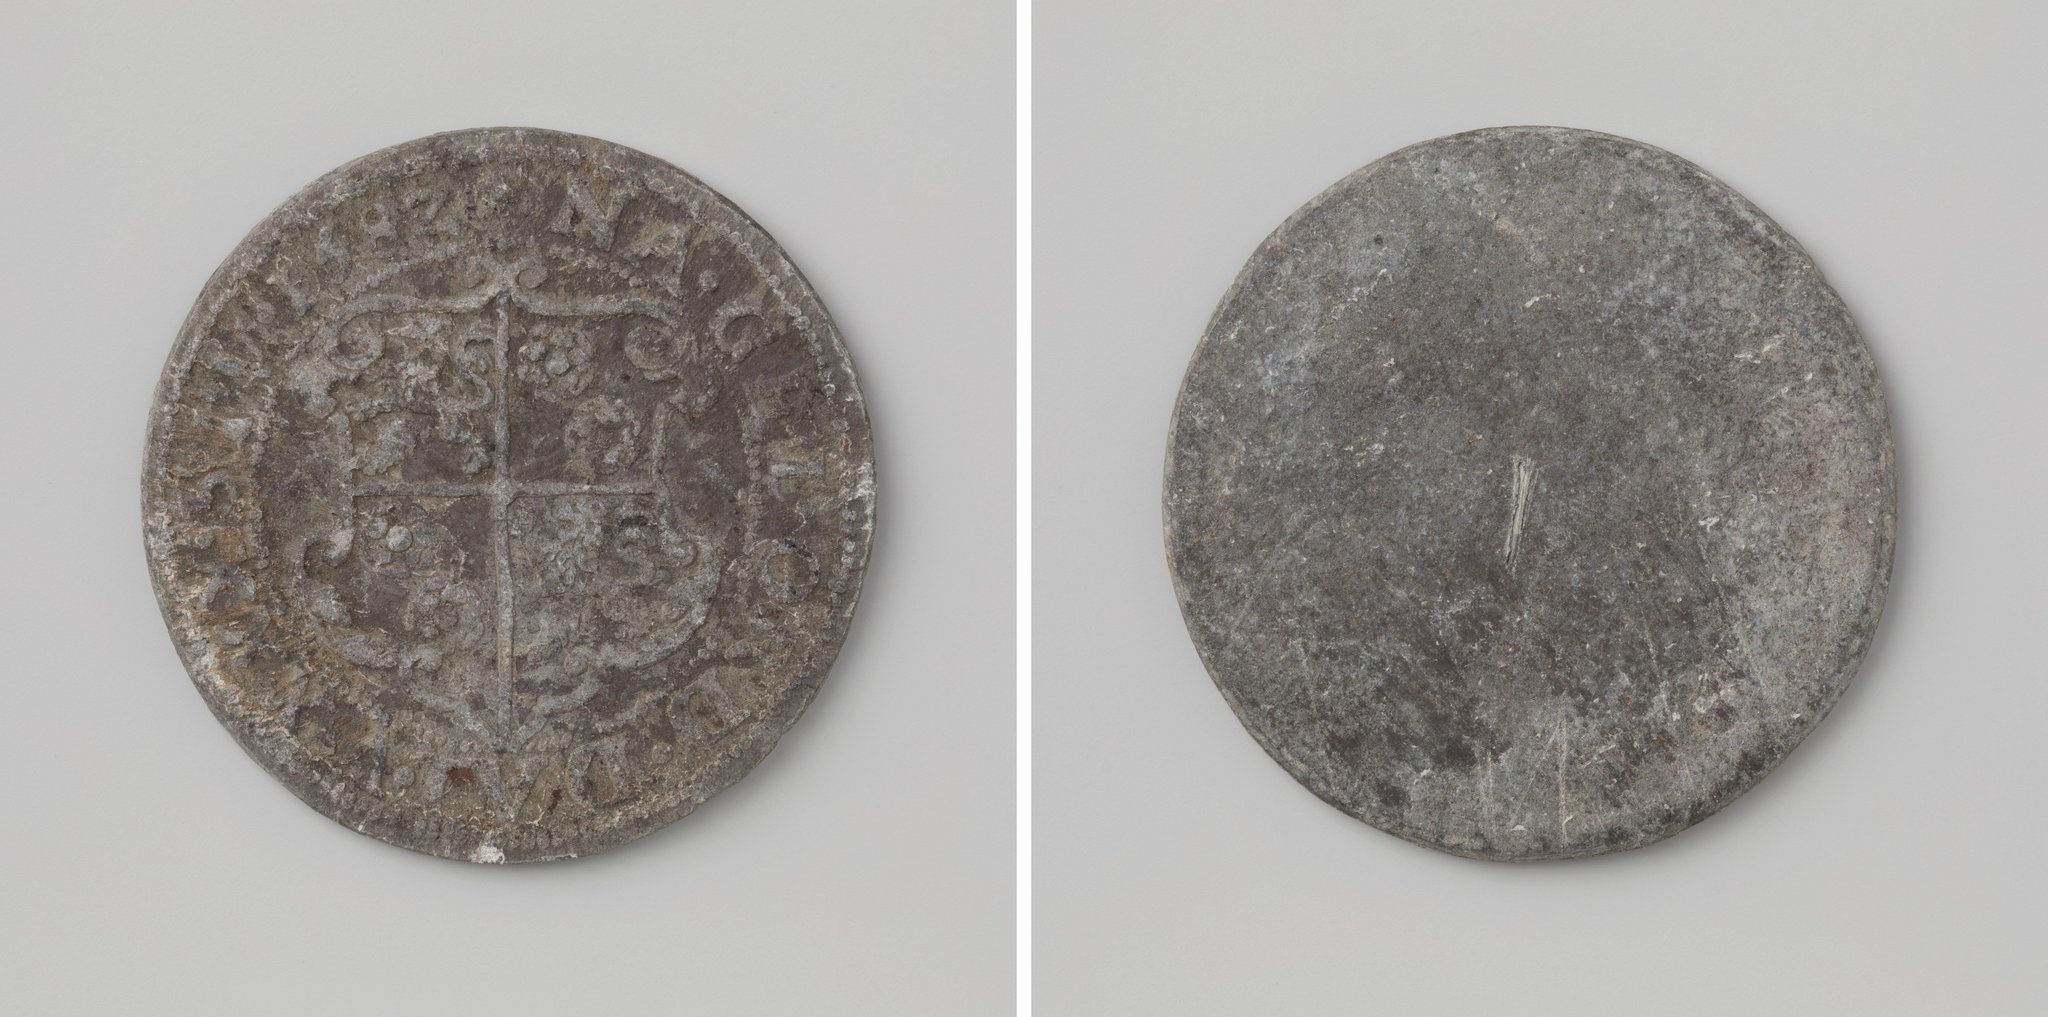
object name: coin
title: Afslag in lood van de voorzijde van een daalder van 30 stuiver van de stad Zaltbommel, 1582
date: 1582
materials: lead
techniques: striking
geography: zaltbommel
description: Loden afslag van een zilveren munt. Voorzijde: gevierendeeld wapenschild van de stad. In omschrift waarde-aanduiding: rozet? NA GEL ORD DAL V XXX STV en jaartal. Afslag in lood, vervaardigd met in Zaltbommel nog aanwezig stempel van de voorzijde.